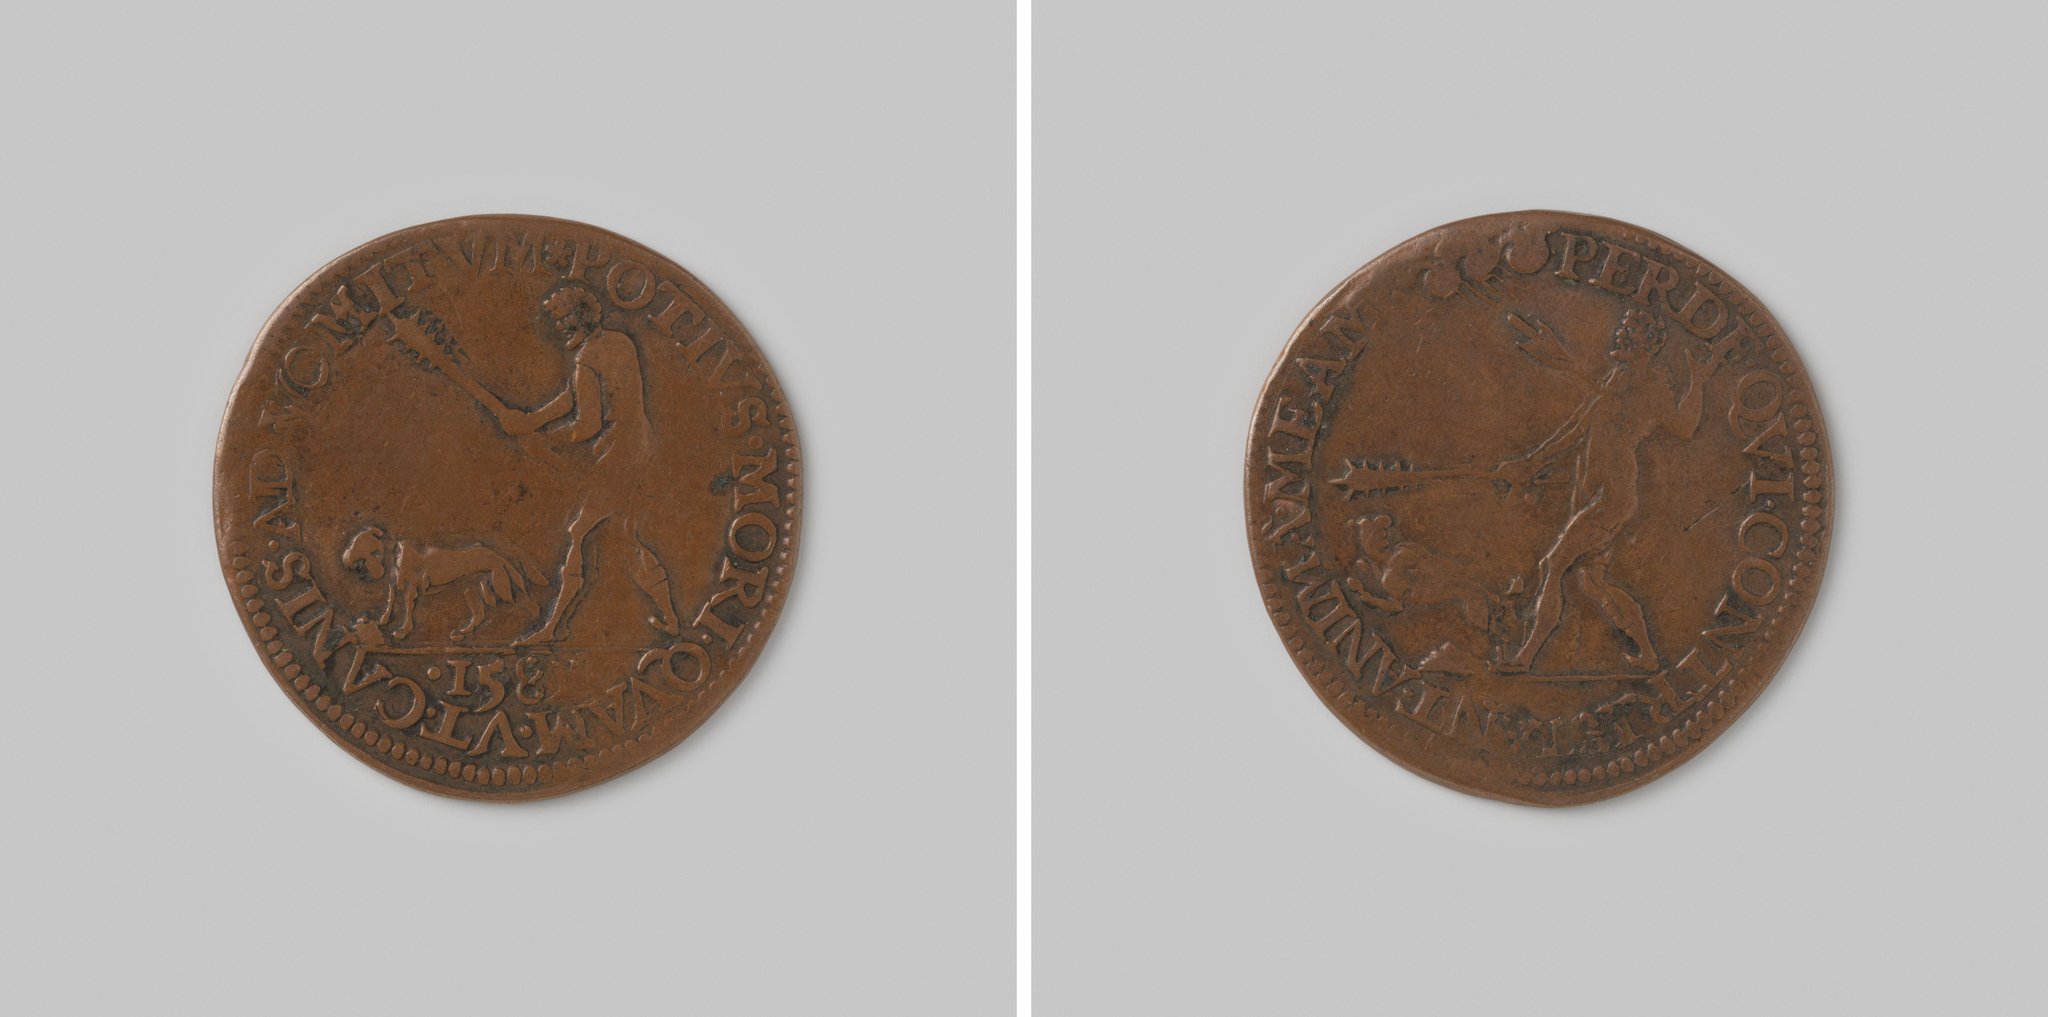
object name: jeton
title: Rekenpenning op het afzweren van Philips II 1581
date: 1581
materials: copper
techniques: striking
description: Koperen penning, op de voorzijde een man met een knots die een hond dwingt zijn braaksel op te eten, met afsnedetekst en omschrift, op de keerzijde de man getroffen door een pijl uit de hemel laat de hond ontsnappen, met omschrift.